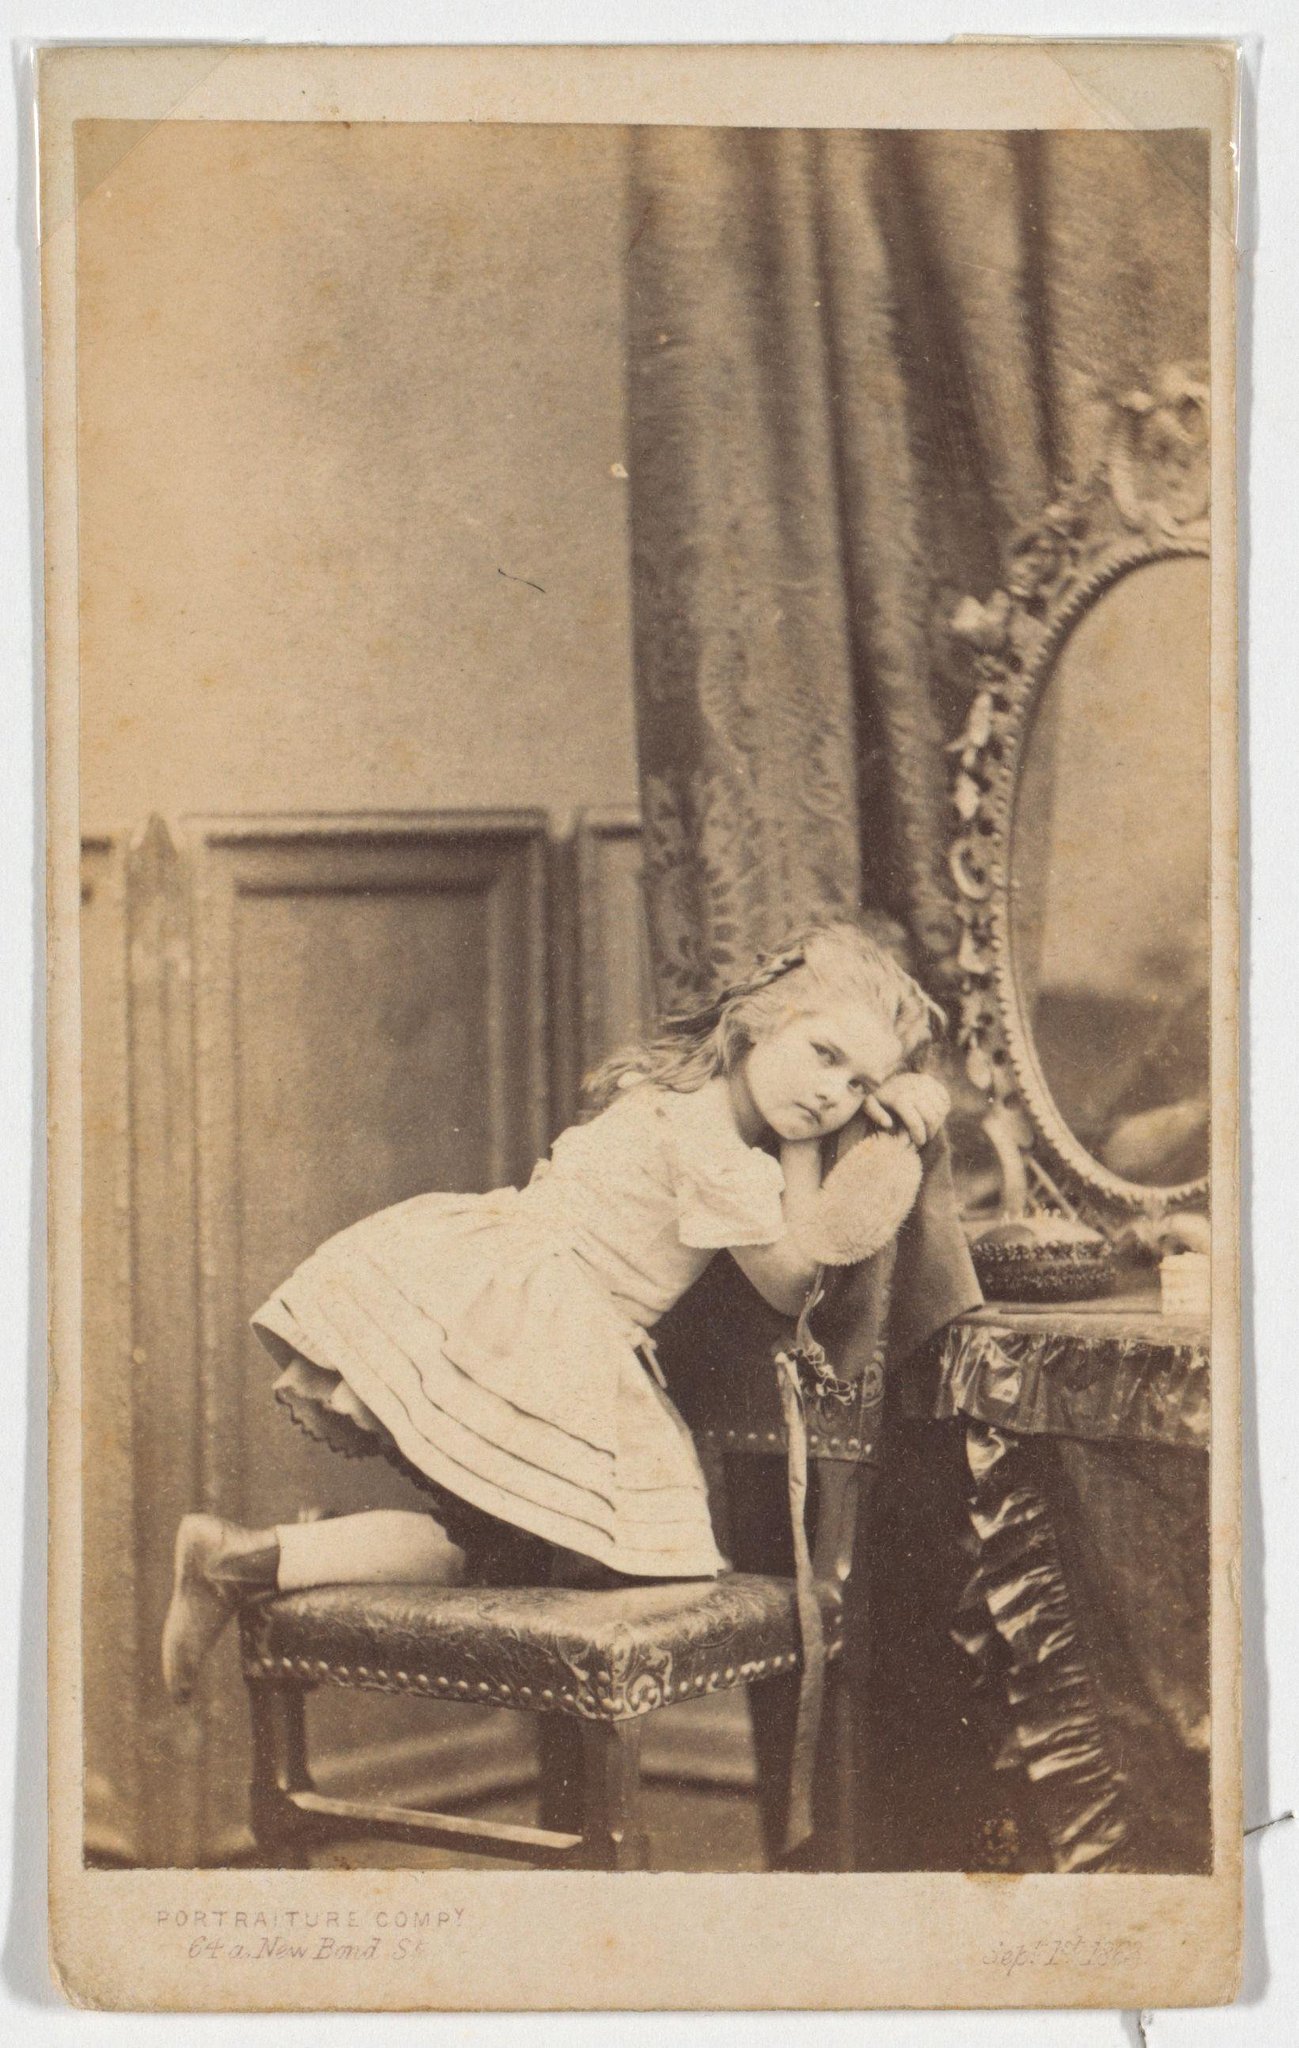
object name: carte de visite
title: Portret van een meisje, knielend op een stoel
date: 1870-1900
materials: cardboard, paper, photographic support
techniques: albumen print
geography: london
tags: studio requisites ~ photographer, historical persons not known by name - bb - woman, london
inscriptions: inscription: ‘Given to Annie by Jennie H[...]’, address: ‘64A New Bond St. corner of Brook St. W’